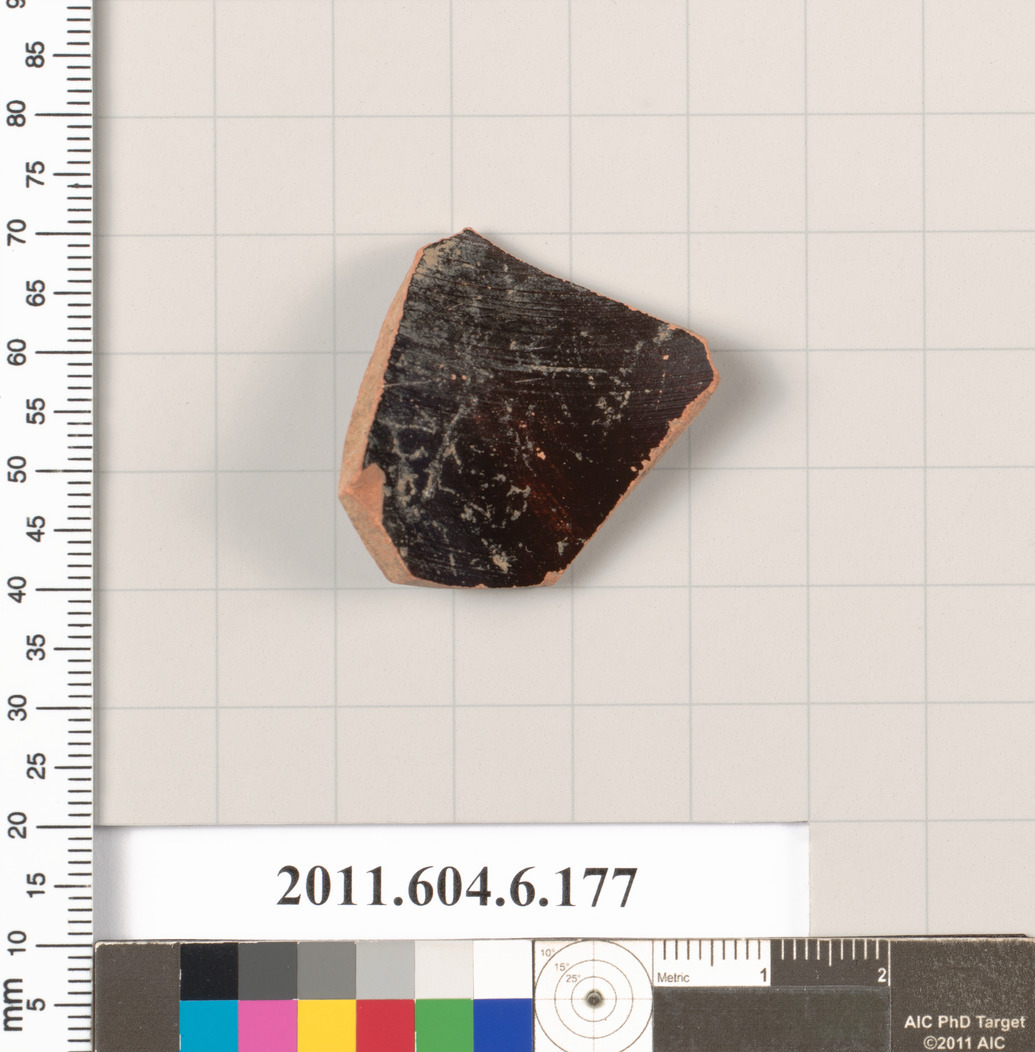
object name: oinochoe fragment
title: Terracotta fragment of an oinochoe (jug)?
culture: greek, attic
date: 500-401 BCE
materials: terracotta